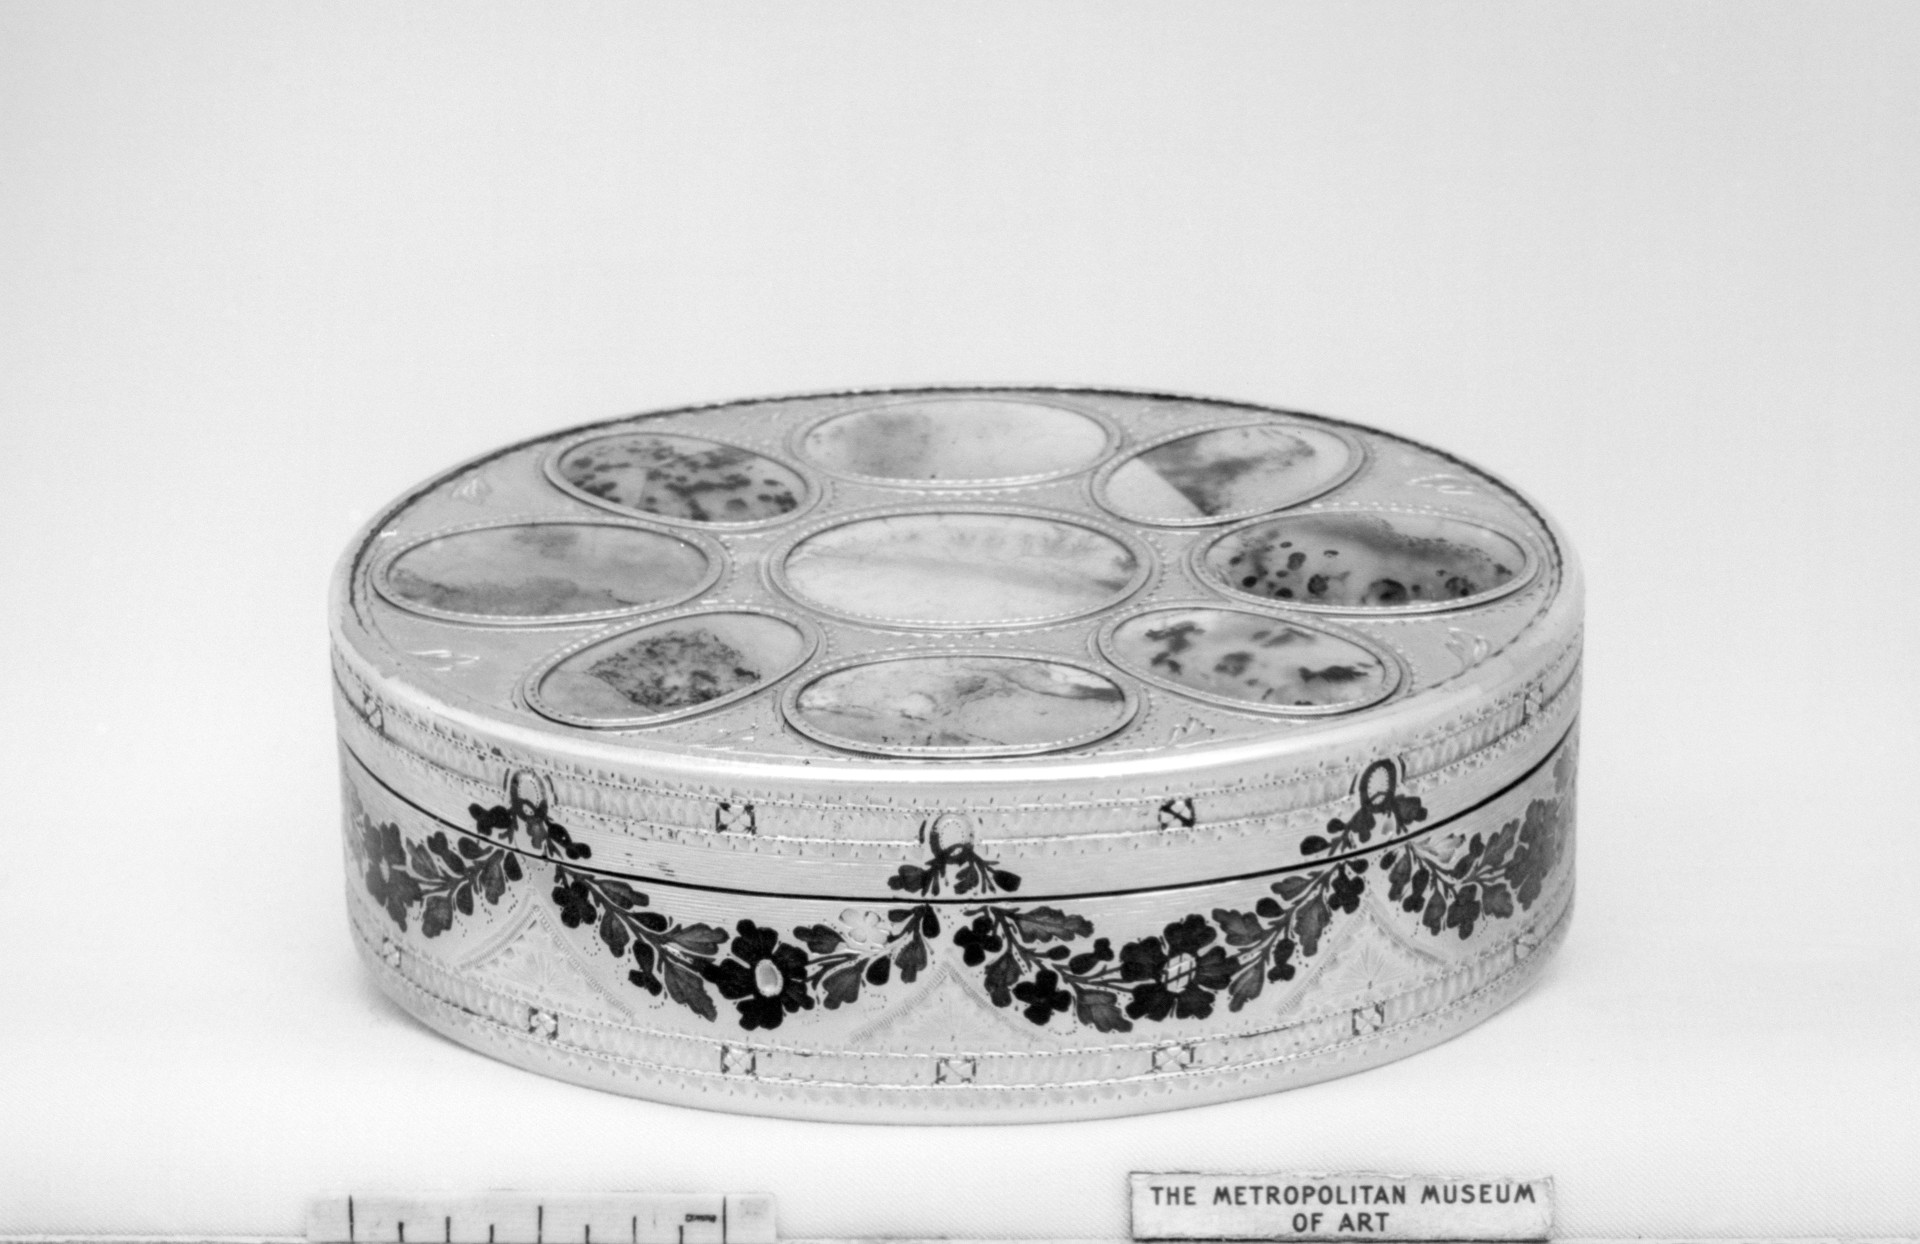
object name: box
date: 1770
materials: enamel, silver, silver gilt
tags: flowers,leaves